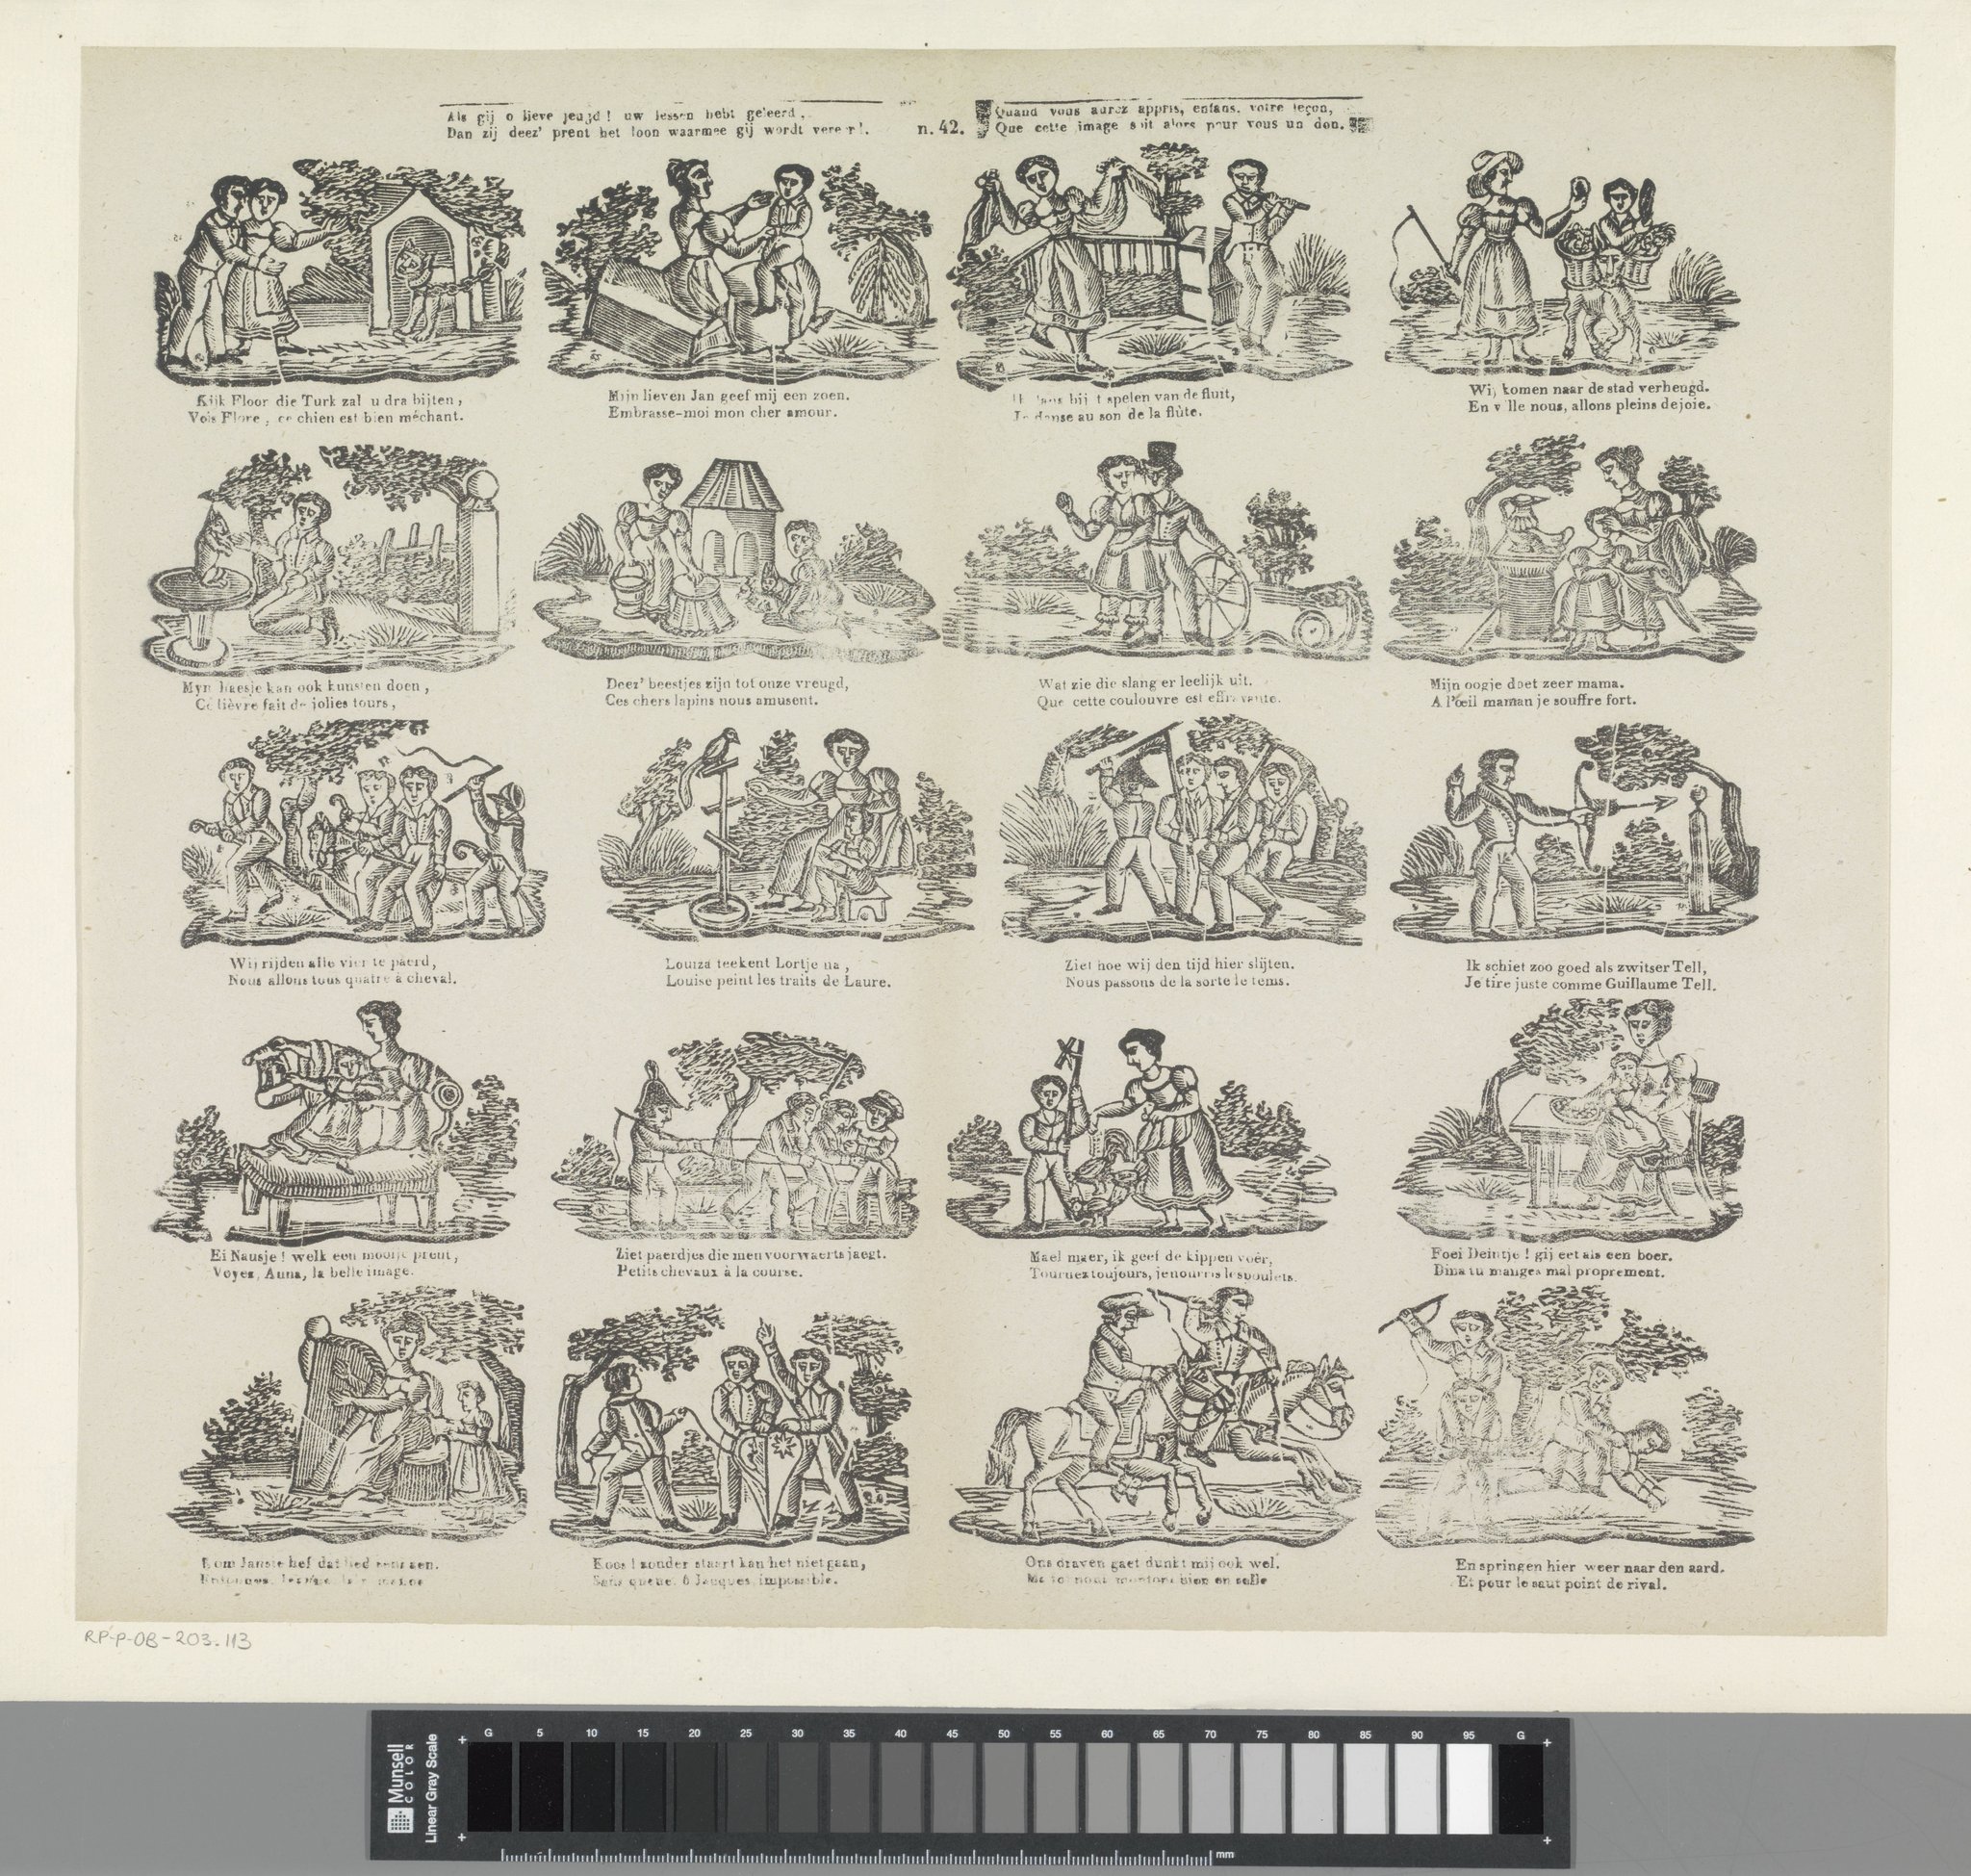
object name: popular print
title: Als gij o lieve jeugd! uw lessen hebt geleerd, / Dan zij deez' prent het loon waarmee gij wordt vereerd / Quand vous aurez appris, enfans, votre leçon, / que zette image soit alors pour vous un don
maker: Anonymous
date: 1856-1900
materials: paper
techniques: letterpress printing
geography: turnhout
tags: children's games and plays, child playing with animals, (flying a) kite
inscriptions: collector's mark: Lugt 2760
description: Blad met 20 voorstellingen van kinderspelen en bezigheden, zoals dansen, harp spelen en vliegeren. Onder elke voorstelling een onderschrift in het Nederlands en in het Frans. Genummerd midden boven: n. 42.